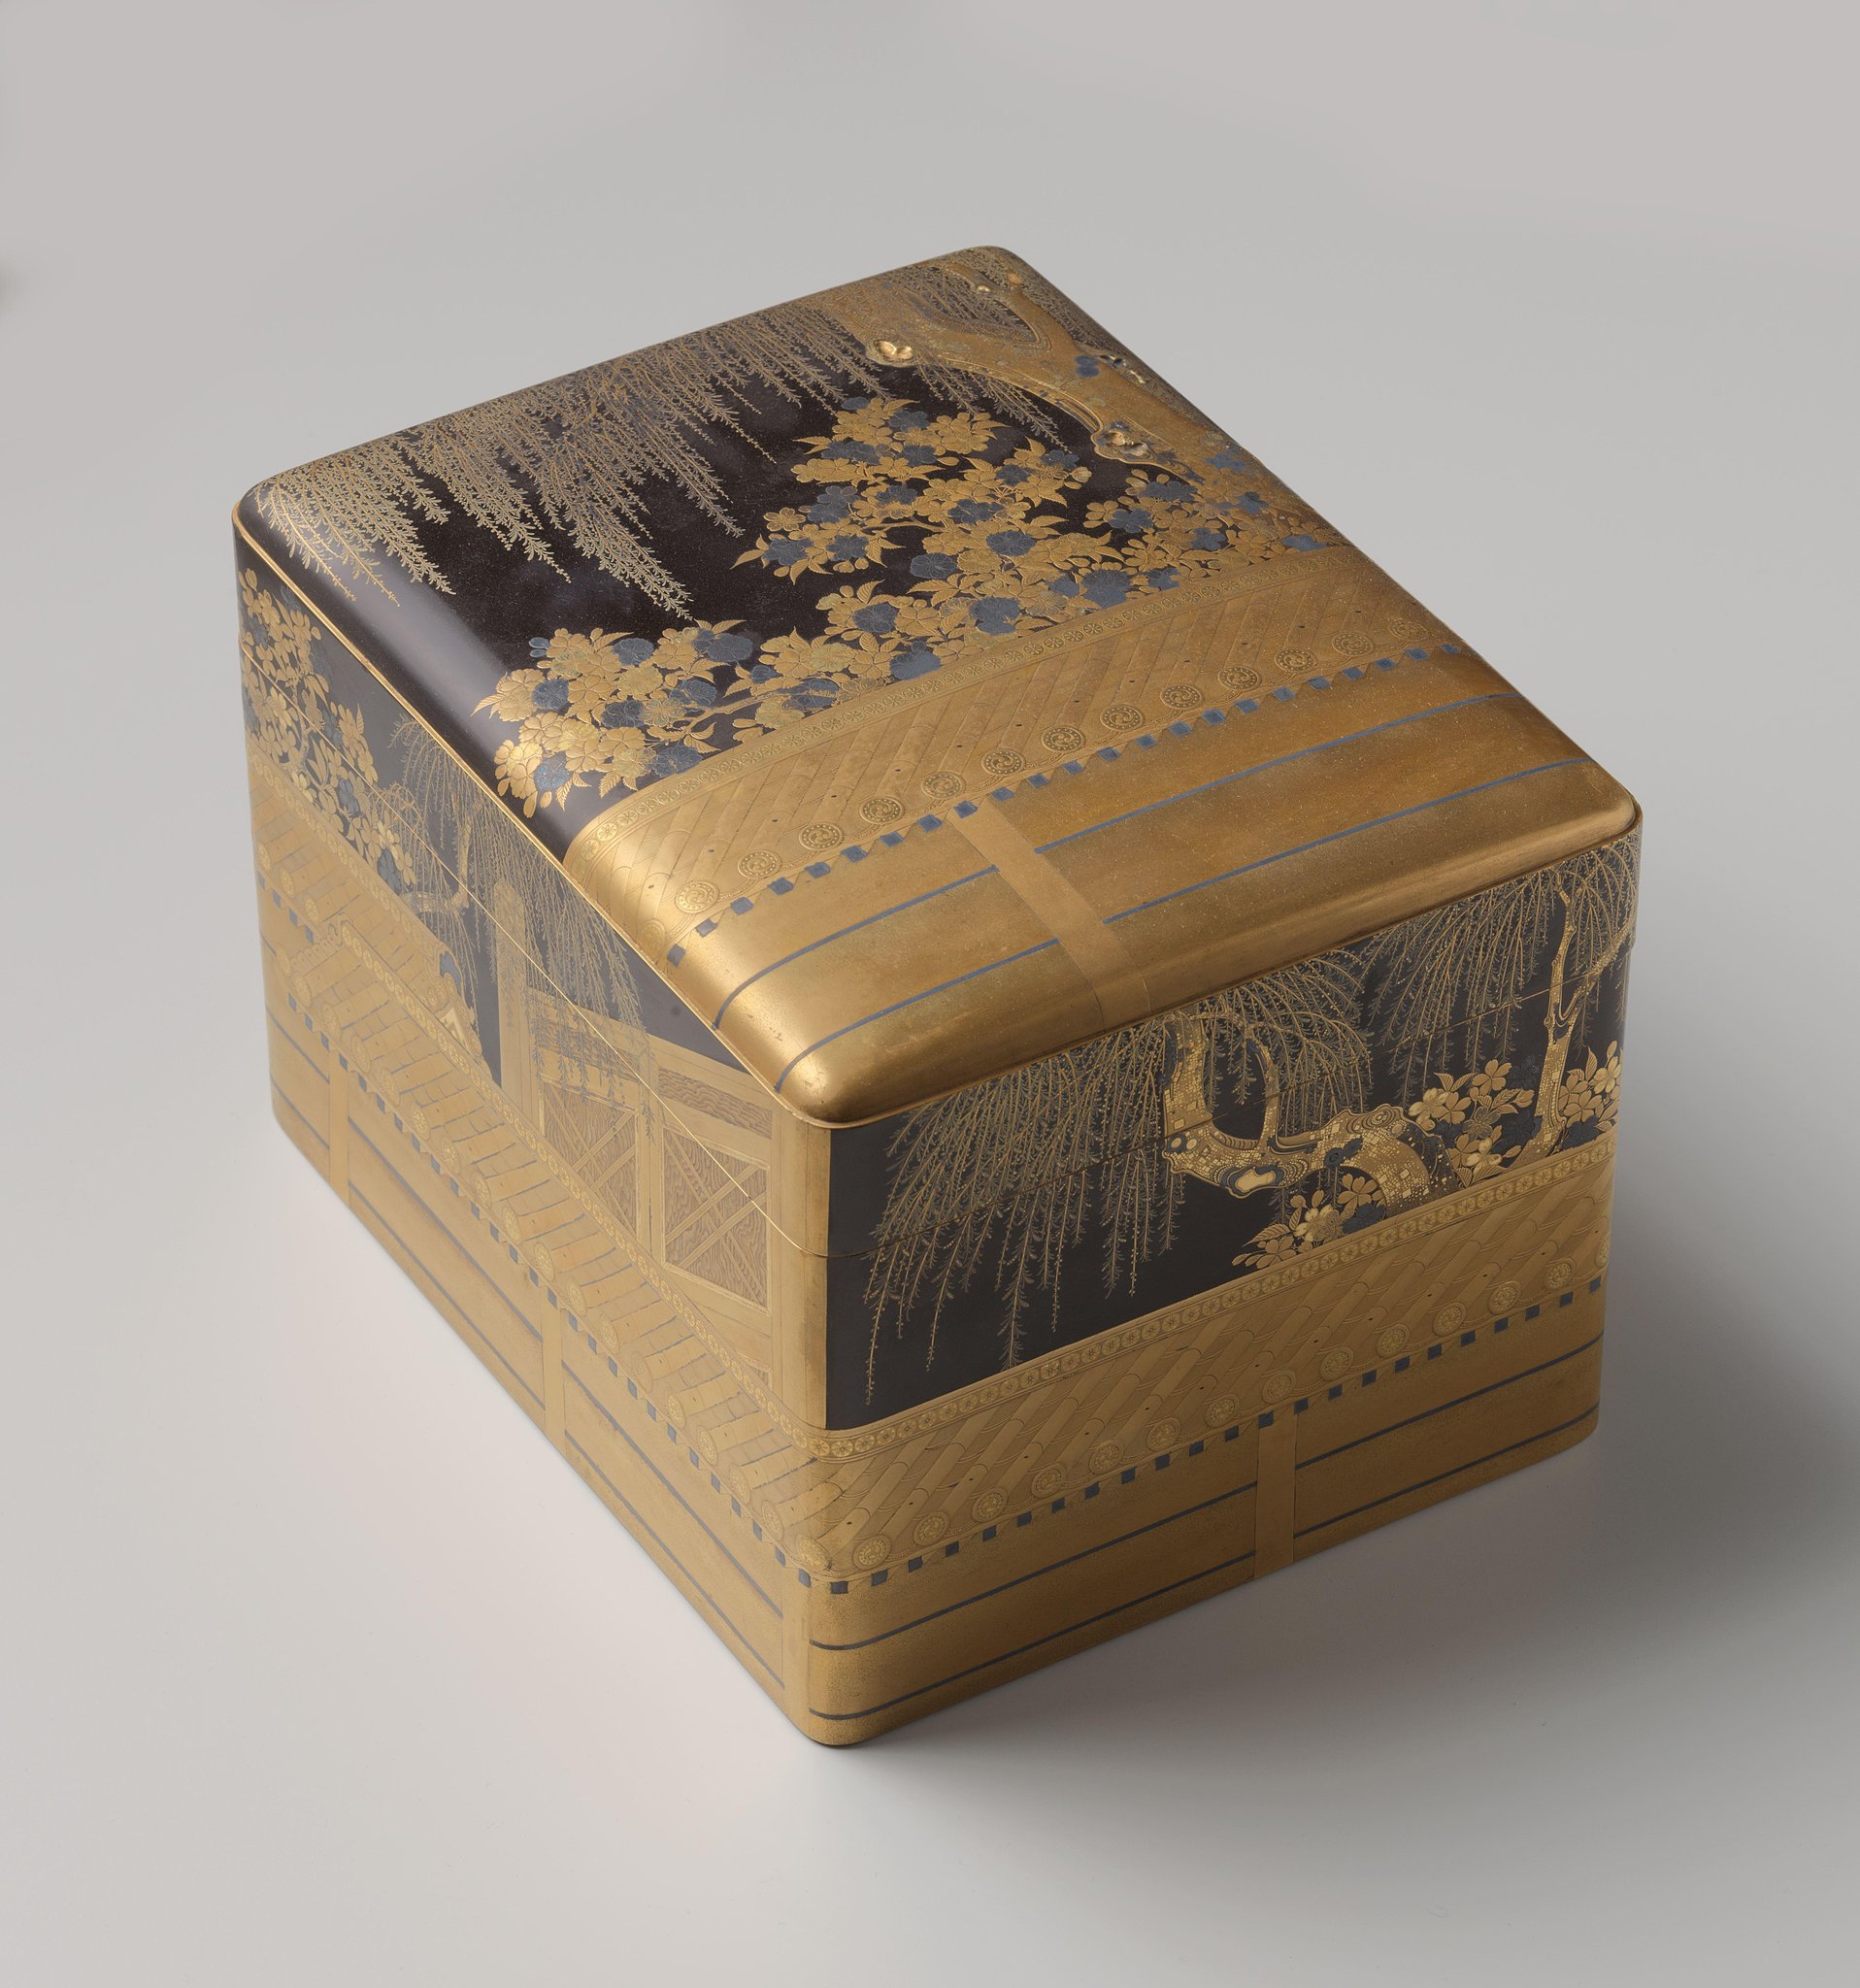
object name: ryoshibako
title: Doos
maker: Anonymous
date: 1725-1825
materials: lacquer, wood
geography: japan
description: Doos met deksel en binnenbak voor schrijfpapier. Decoratie van een tuin-omheining met bloesems en treurwilgen die daar bovenuit rijzen.